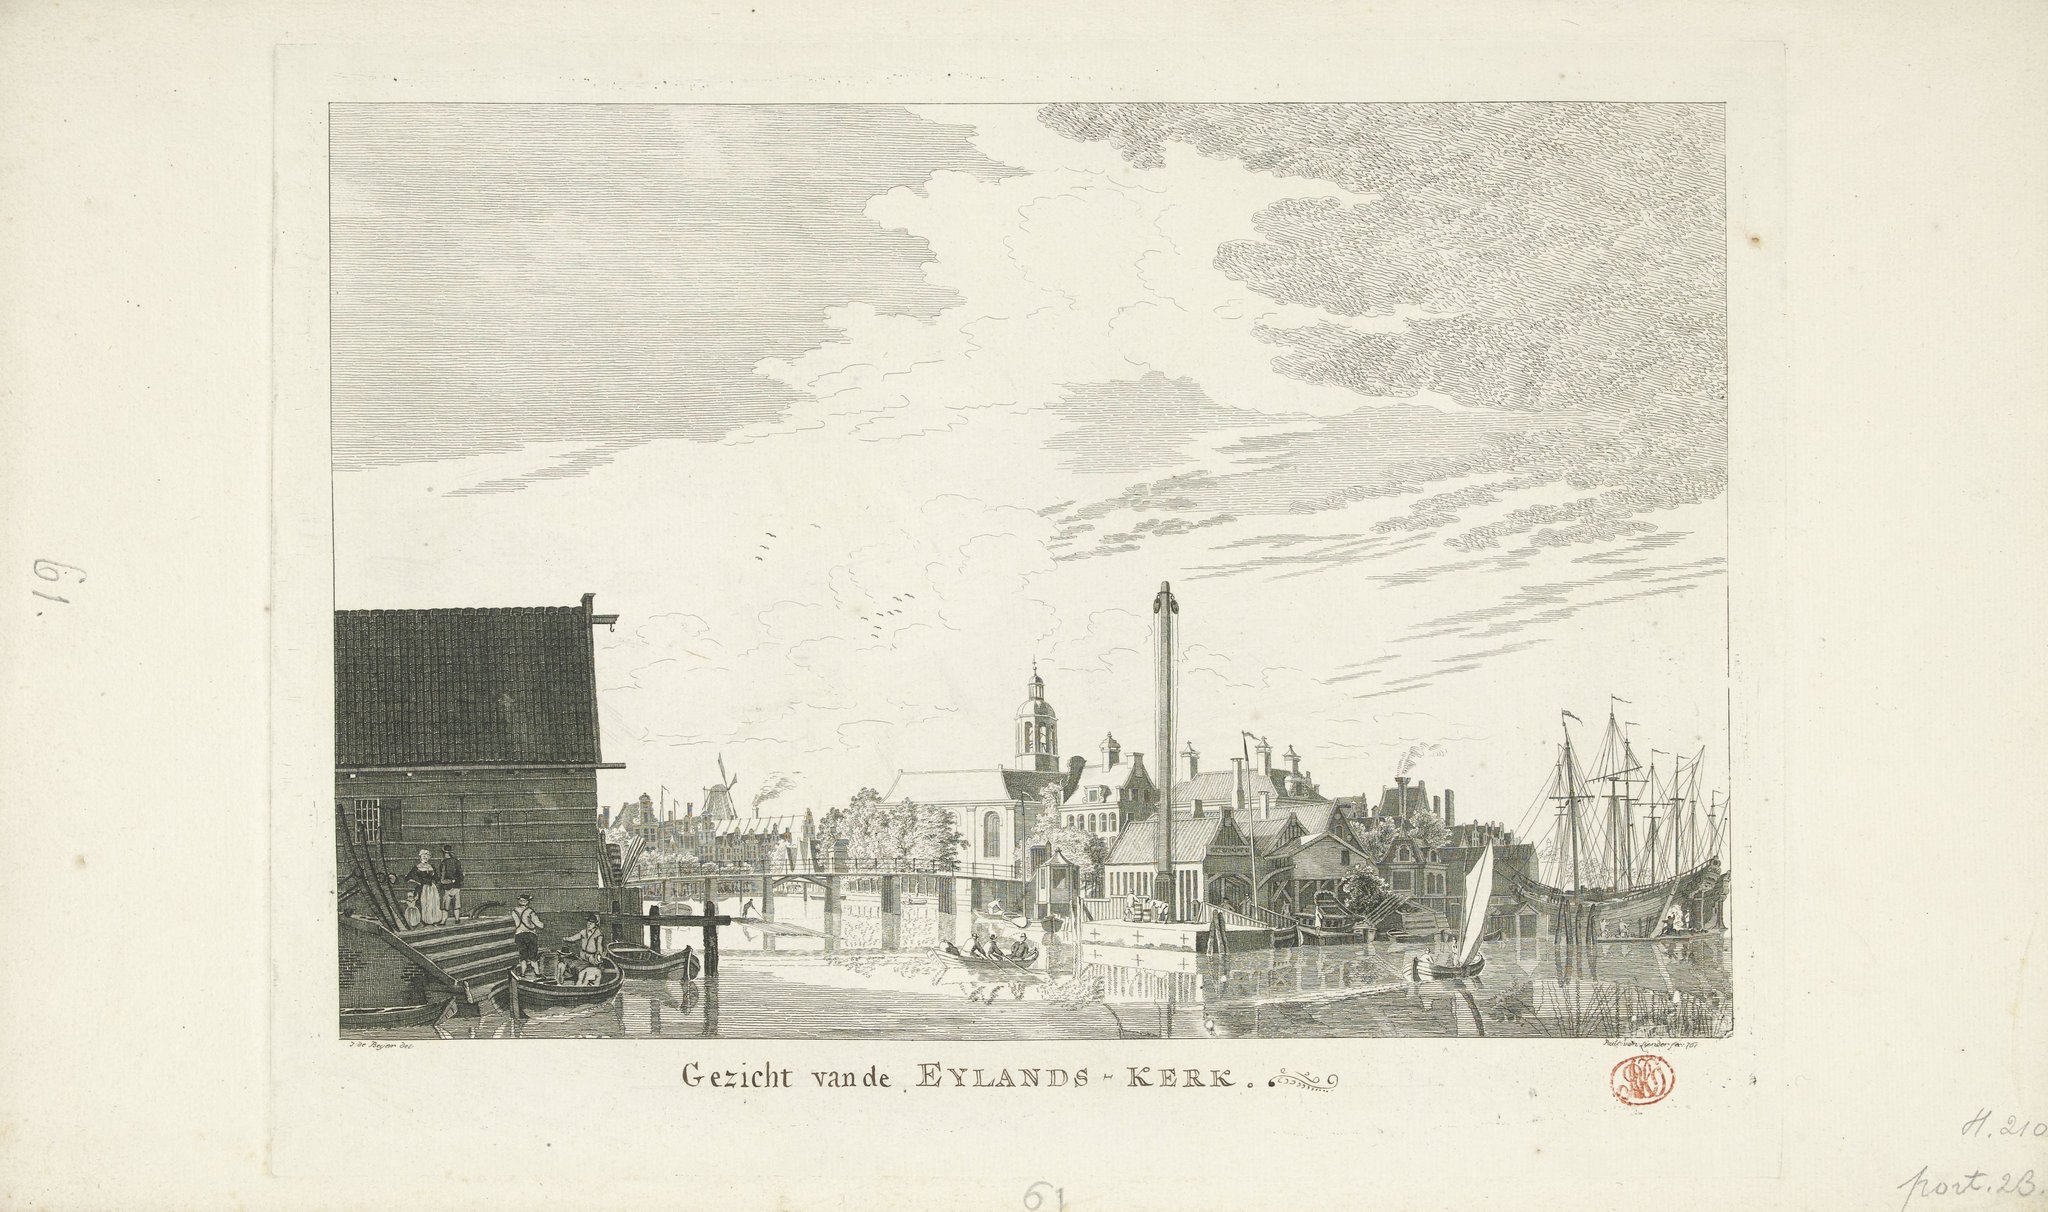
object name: print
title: Gezicht op de Eilandskerk te Amsterdam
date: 1761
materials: ink, paper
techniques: etching, pen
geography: amsterdam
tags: ships (in general), church (exterior), canals, waters (in city), pier, quay, wharf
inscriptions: collector's mark: Lugt 195, inscription: ‘Gezicht vande Eylands-Kerk’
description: Latere staten van deze prent zijn ook gebruikt in de zogenaamde Atlas van Fouquet.* Pierre Fouquet gaf vanaf 1760 stadsgezichten van Amsterdam - naar tekeningen van verschillende kunstenaars, gemaakt door verschillende prentmakers - uit. Deze prenten werden aanvankelijk los of in series verkocht. Zoals toen gebruikelijk kon de koper de prenten zelf laten inbinden. Hiertoe gaf Fouquet tussen 1778 en 1783 een titelblad, plattegrond en inhoudsopgave van de tot dusver 100 uitgegeven prenten uit (1). Gezien de inhoud afhankelijk was van wat de koper had verzameld verschilt de inhoud van de verschillende bewaarde Fouquetatlassen onder deze titel sterk. Ook zijn er exemplaren bekend waar tevens andere prenten aan zijn toegevoegd. Omdat er behoefte bleek aan uitleg bij de platen werd in 1783 een nieuwe versie van de atlas uitgegeven, aangevuld met tekst en twee prenten. De aangegeven volgorde veranderde maar de platen van de al eerder uitgegeven prenten bleven ongewijzigd. Deze uitgave werd in opdracht van Fouquet gedrukt bij Daniël Jean Changuion en Petrus den Hengst (2). Een tiental platen werd bijgewerkt en verscheen, met nieuw impressum, in het vervolg van Wagenaars geschiedenis van Amsterdam, uitgeven door Petrus Conradi en Folkert van der Plaats (3). Een aantal jaar na het overlijden van Fouquet kwam Evert Maaskamp met een nieuwe uitgave van de atlas, met verbeterde tekst en toevoeging van twee prenten. Op alle platen verwijderde hij het oude en liet hij zijn eigen impressum zetten (4). * Onder de Atlas van Fouquet of Fouquetatlas verstaan we de hieronder vermelde publicaties (1), (2) en (4). (1). Afbeeldingen van de wyd-vermaarde koopstad Amsterdam benevens des zelvs voornaamste gebouwen en gezigten alle naar het leeven getekend / Receuil des edifices les plus considerables et des plus belles vues, de la fameuse ville d'Amsterdam, dessinées d'après nature. Amsterdam: Pierre Fouquet, 1778-1783. (2). Nieuwe atlas, van de voornaamste gebouwen en gezigten der stad Amsterdam, met derzelver beknopte beschryvingen. 2 delen. Amsterdam: Daniël Jean Changuion en Petrus den Hengst [in opdracht van Pierre Fouquet], 1783. (3). Stijl, Simon. Amsterdam, in zyne geschiedenissen, voorregten, koophandel, gebouwen, kerkenstaat, schoolen, schutterye, gilden en regeeringe, beschreeven. Om te dienen ten vervolge op het werk van Jan Wagenaar (…). 10 delen. Amsterdam en Harlingen: Petrus Conradi en Folkert van der Plaats, 1788-1801. (4). Nieuwe atlas, van de voornaamste gebouwen en gezigten der stad Amsterdam. Met derzelver beknopte beschryvingen. Amsterdam: Evert Maaskamp, 1805. * Het aantal vermelde staten is gebaseerd op het aantal gevonden staten. Mogelijk zijn er meer staten van deze prent. Voor tweede bekende staat zie RP-P-OB-46.354. Voor derde bekende staat zie RP-P-AO-23-61A. Voor vierde bekende staat zie RP-P-1998-777.